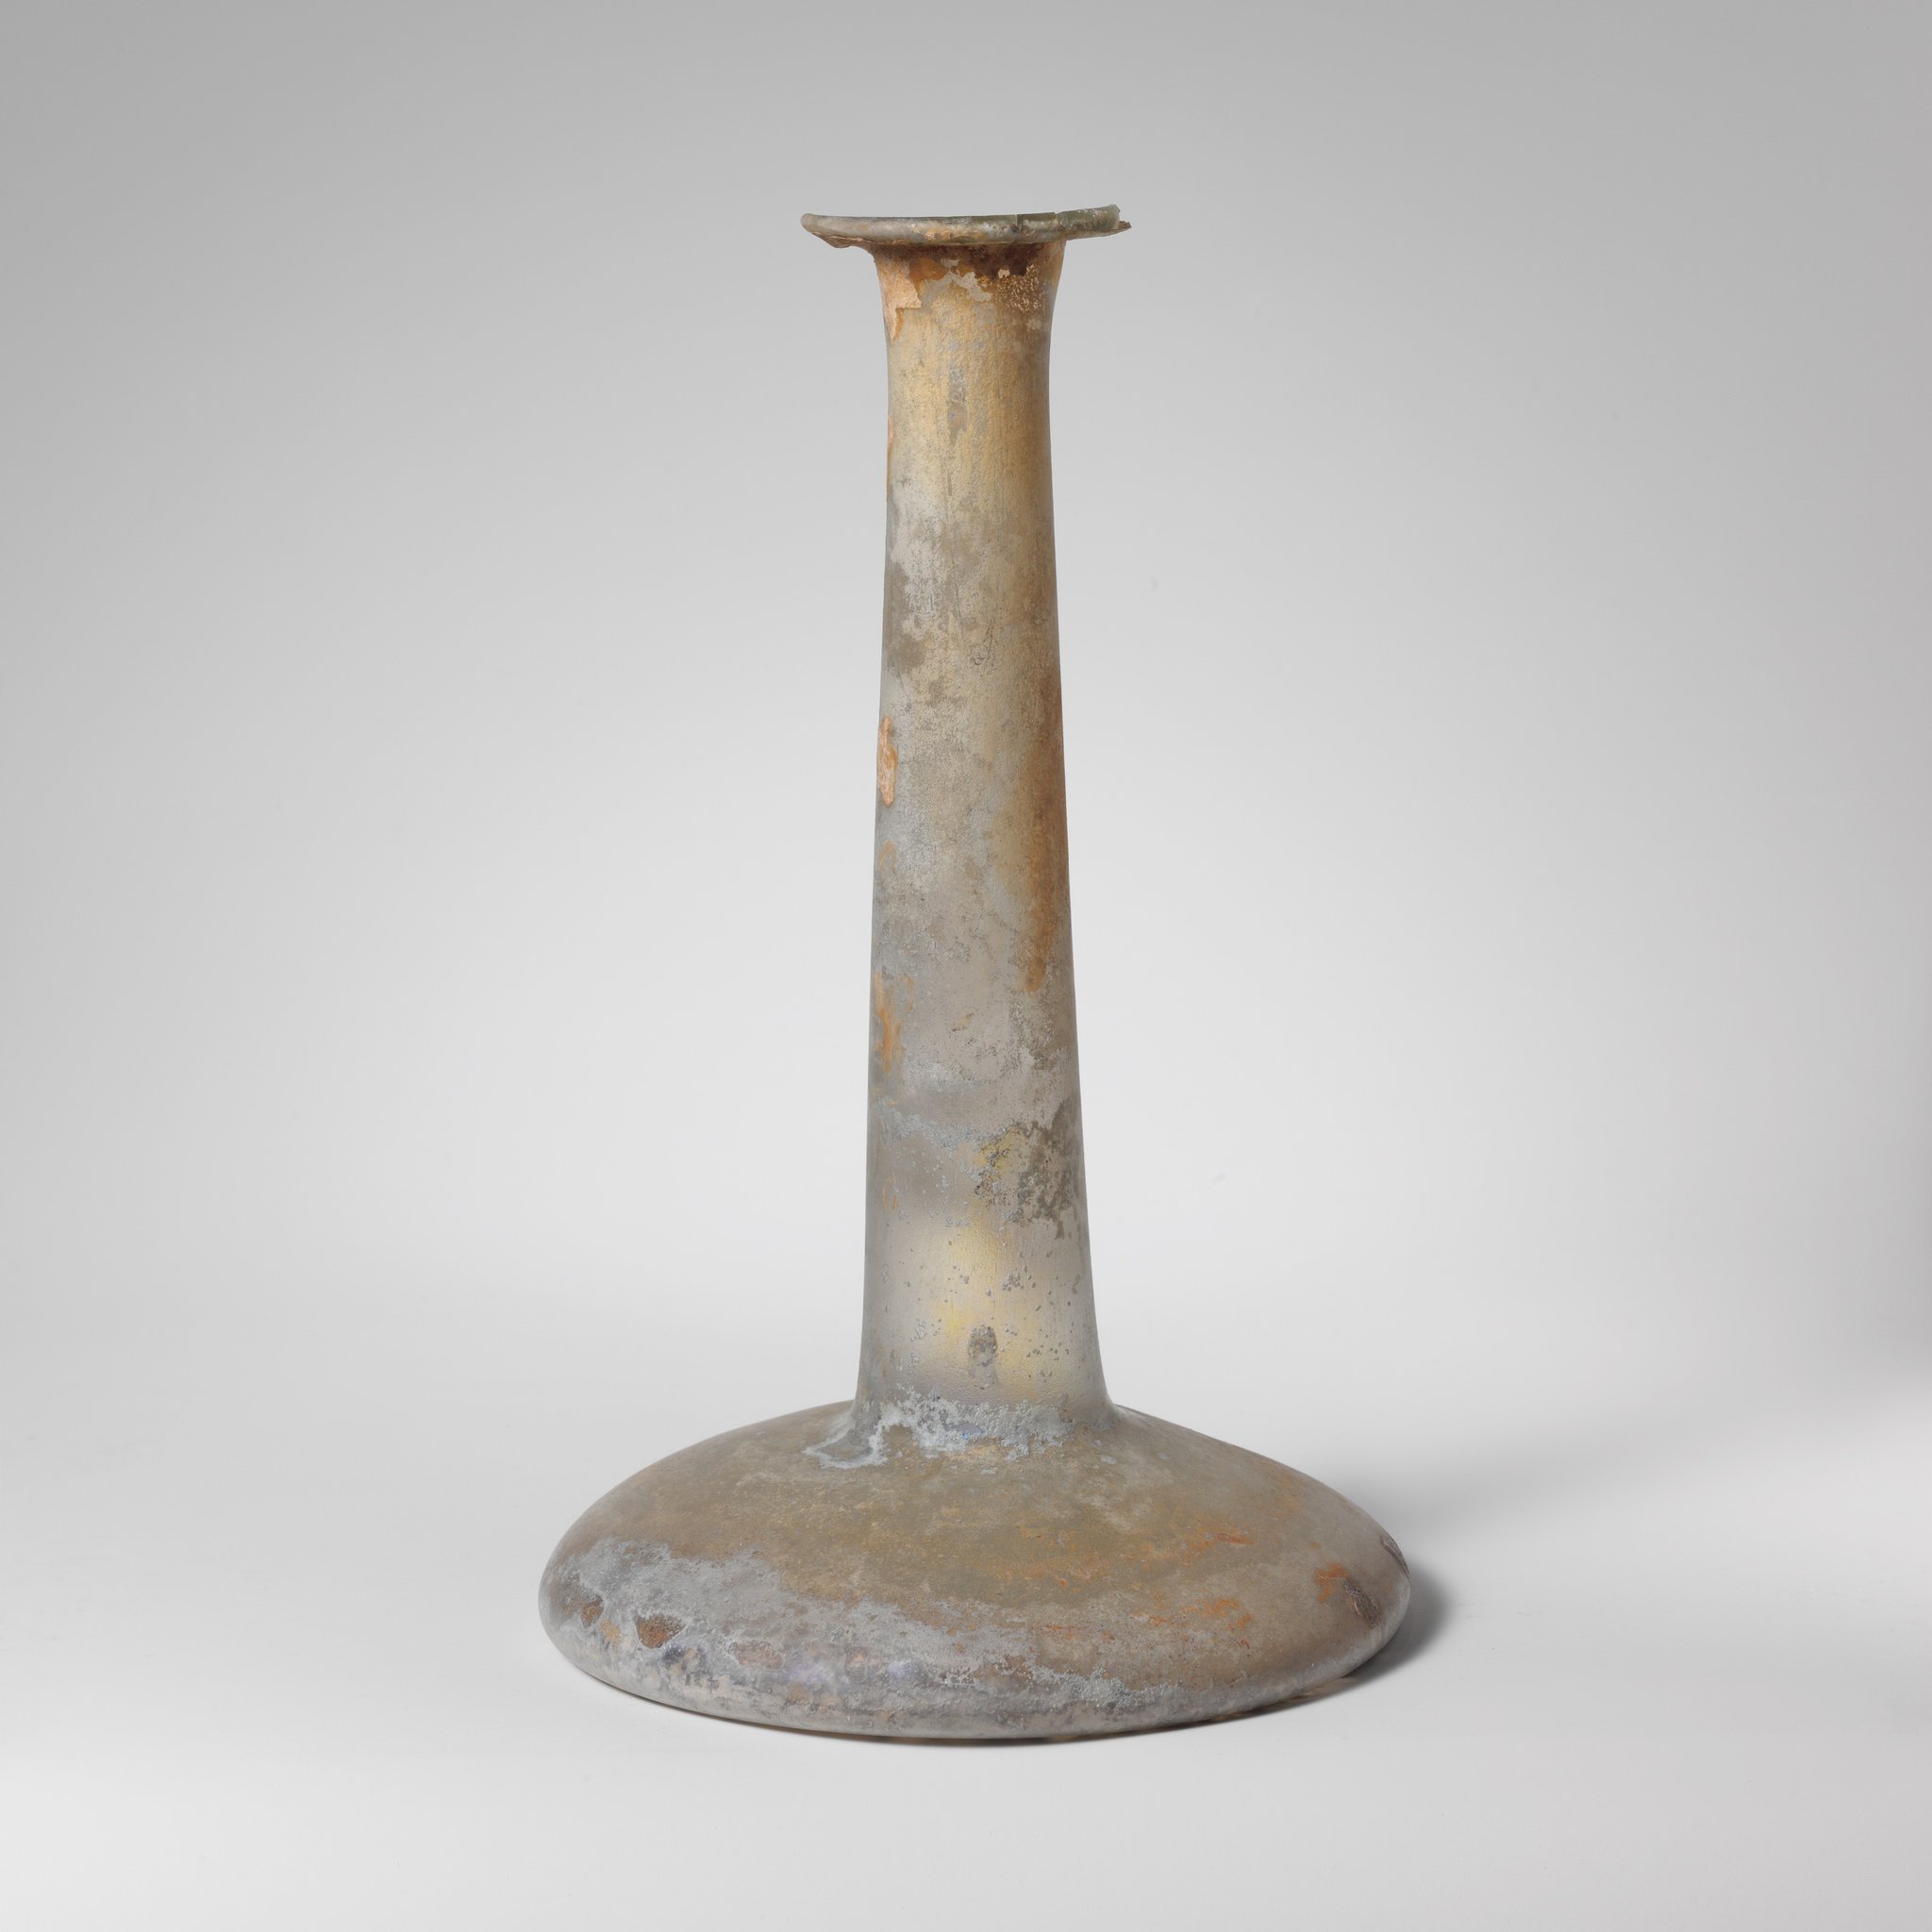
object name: candlestick perfume bottle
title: Glass perfume bottle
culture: roman, cypriot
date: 101-300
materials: glass